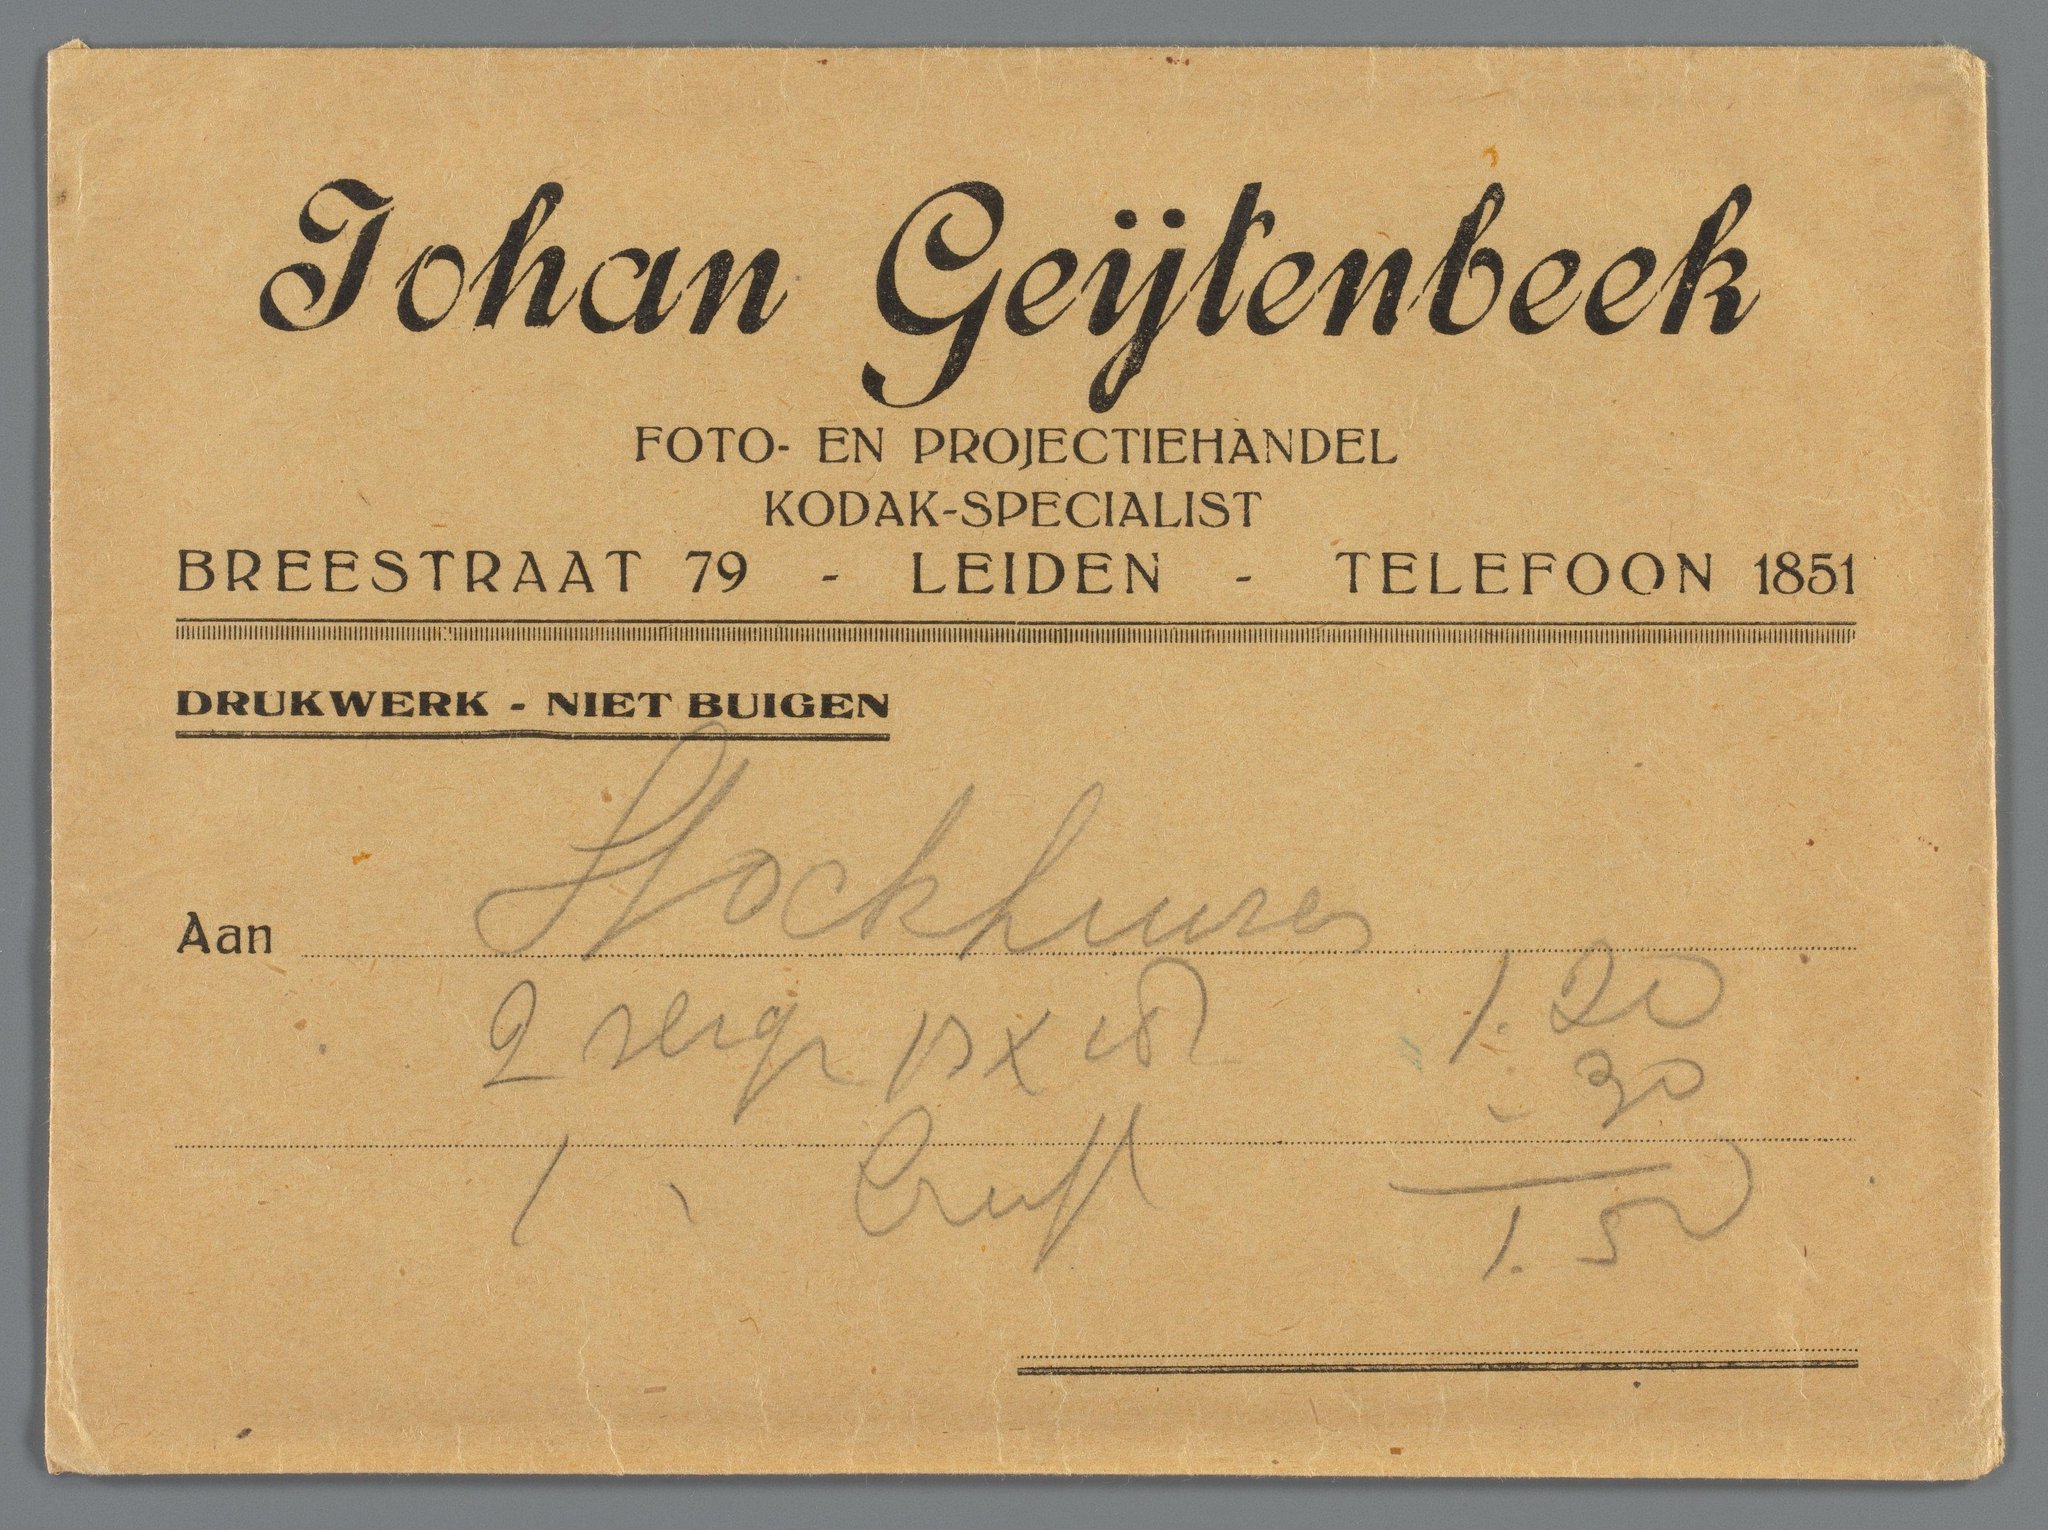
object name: envelope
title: Envelop voor foto's van Johan Geijtenbeek te Leiden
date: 1914-1950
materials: paper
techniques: letterpress printing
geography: leiden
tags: letter, envelope